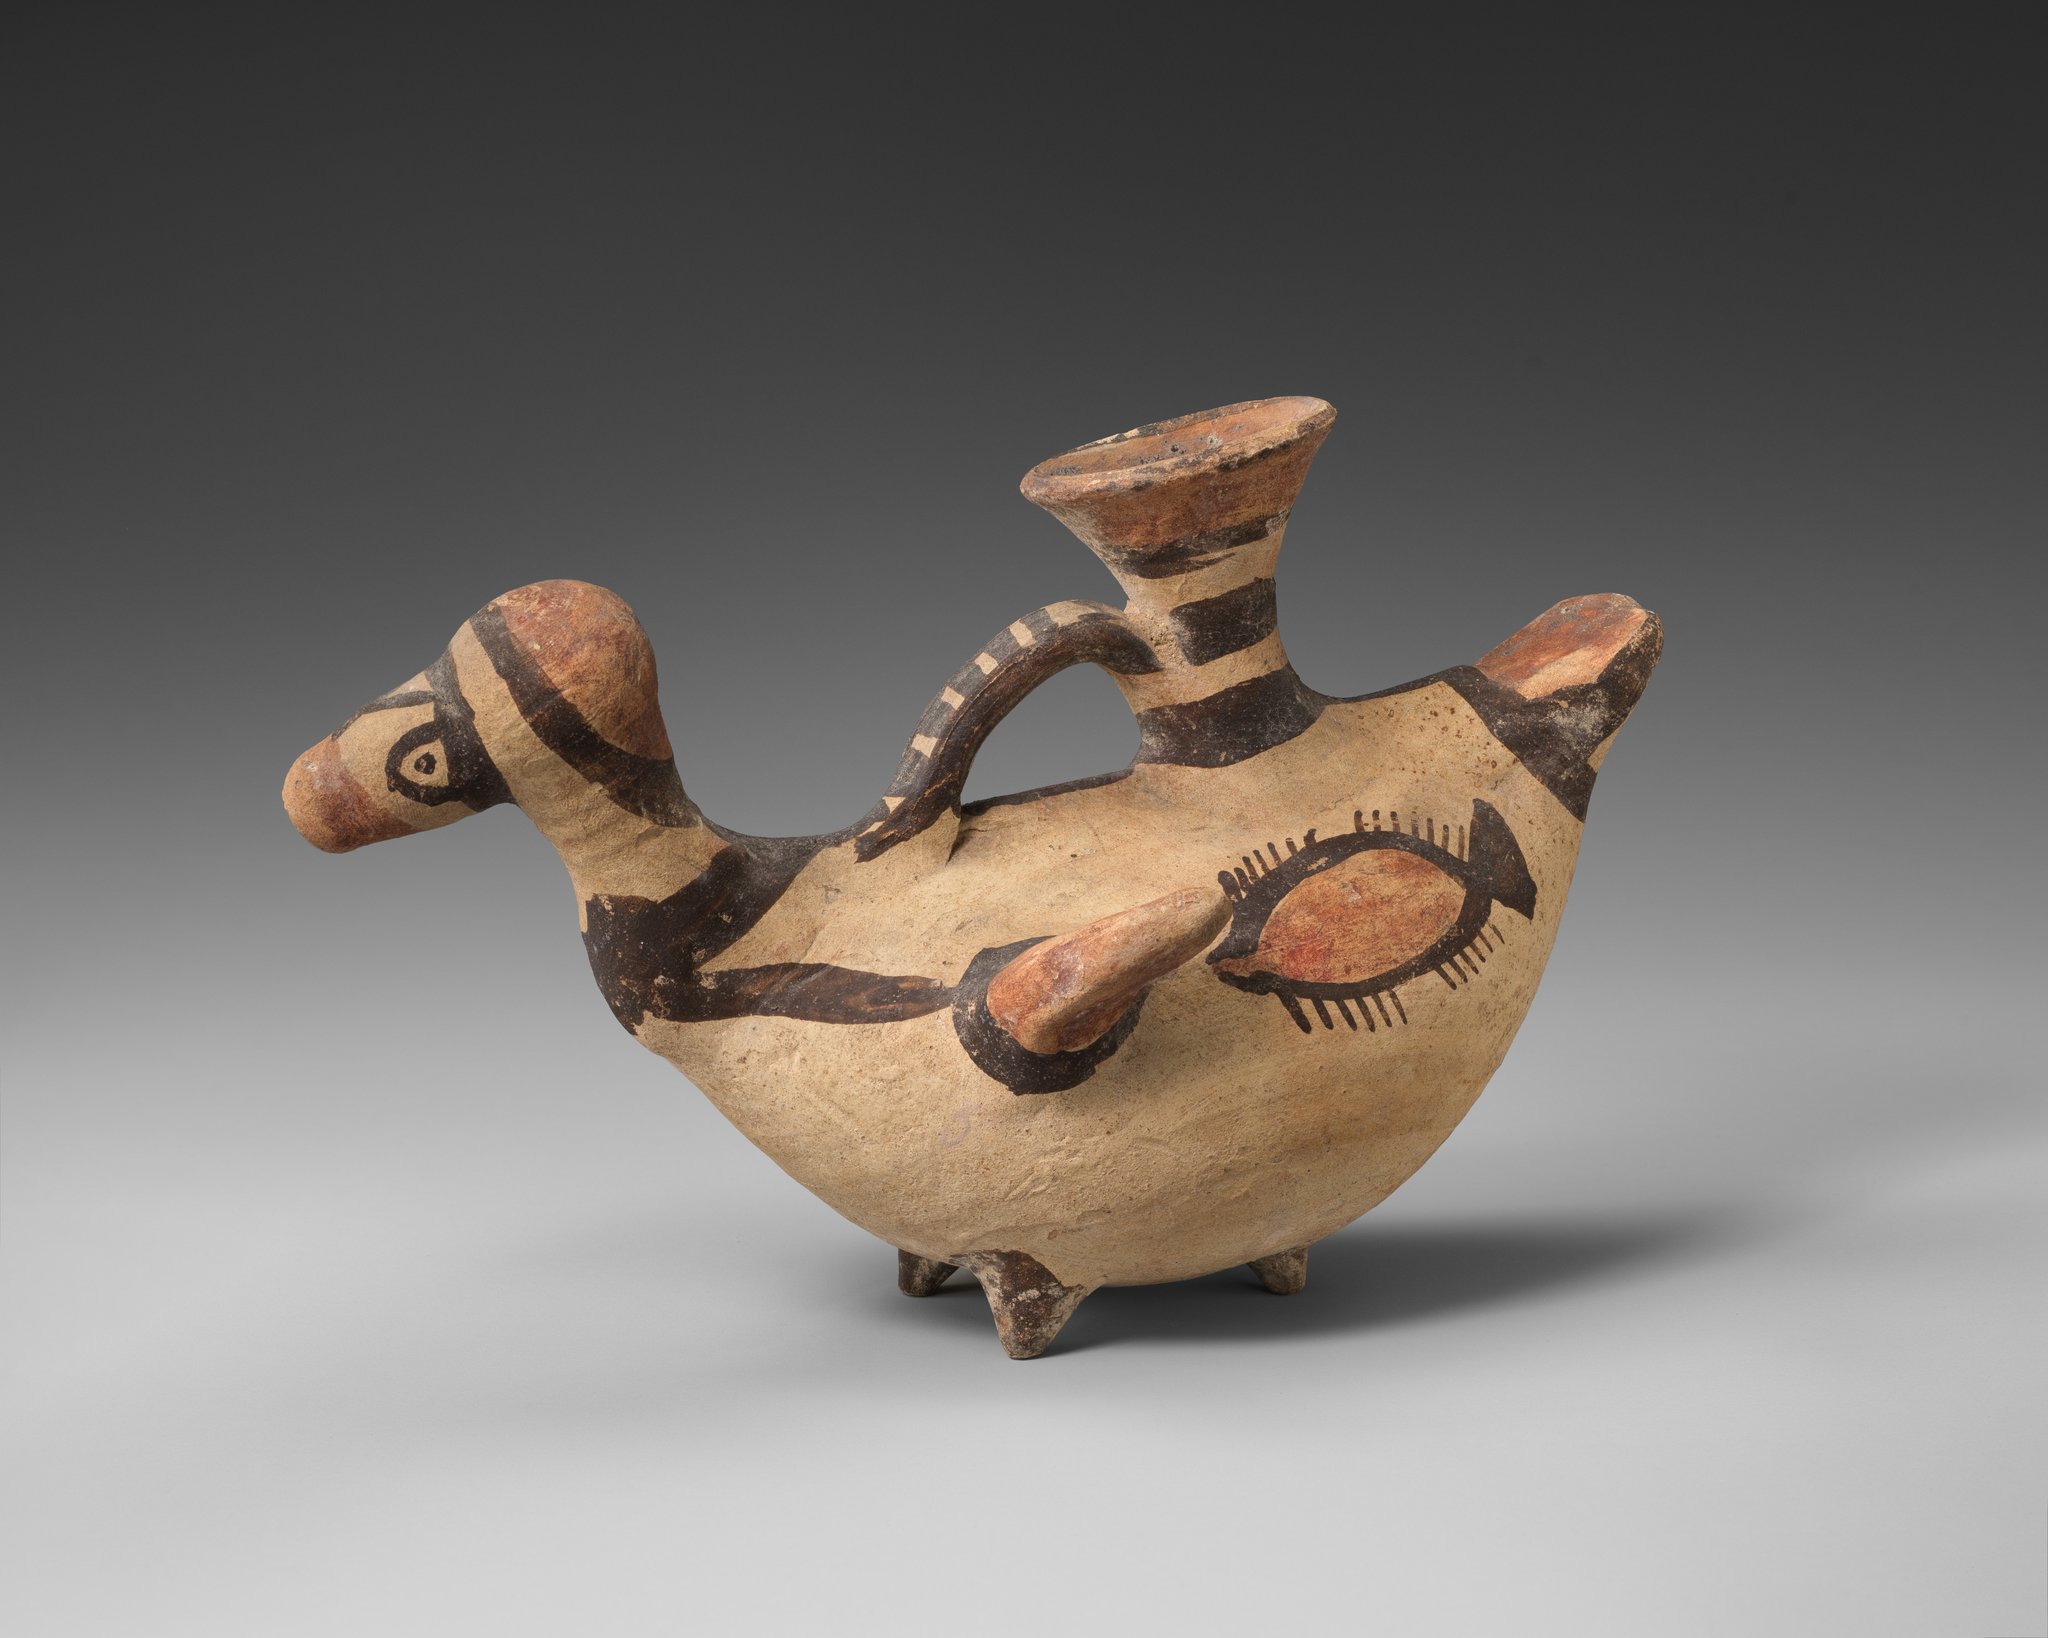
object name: vase in the form of a duck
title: Terracotta bird-shaped vase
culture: cypriot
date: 850-750 BCE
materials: terracotta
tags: ducks